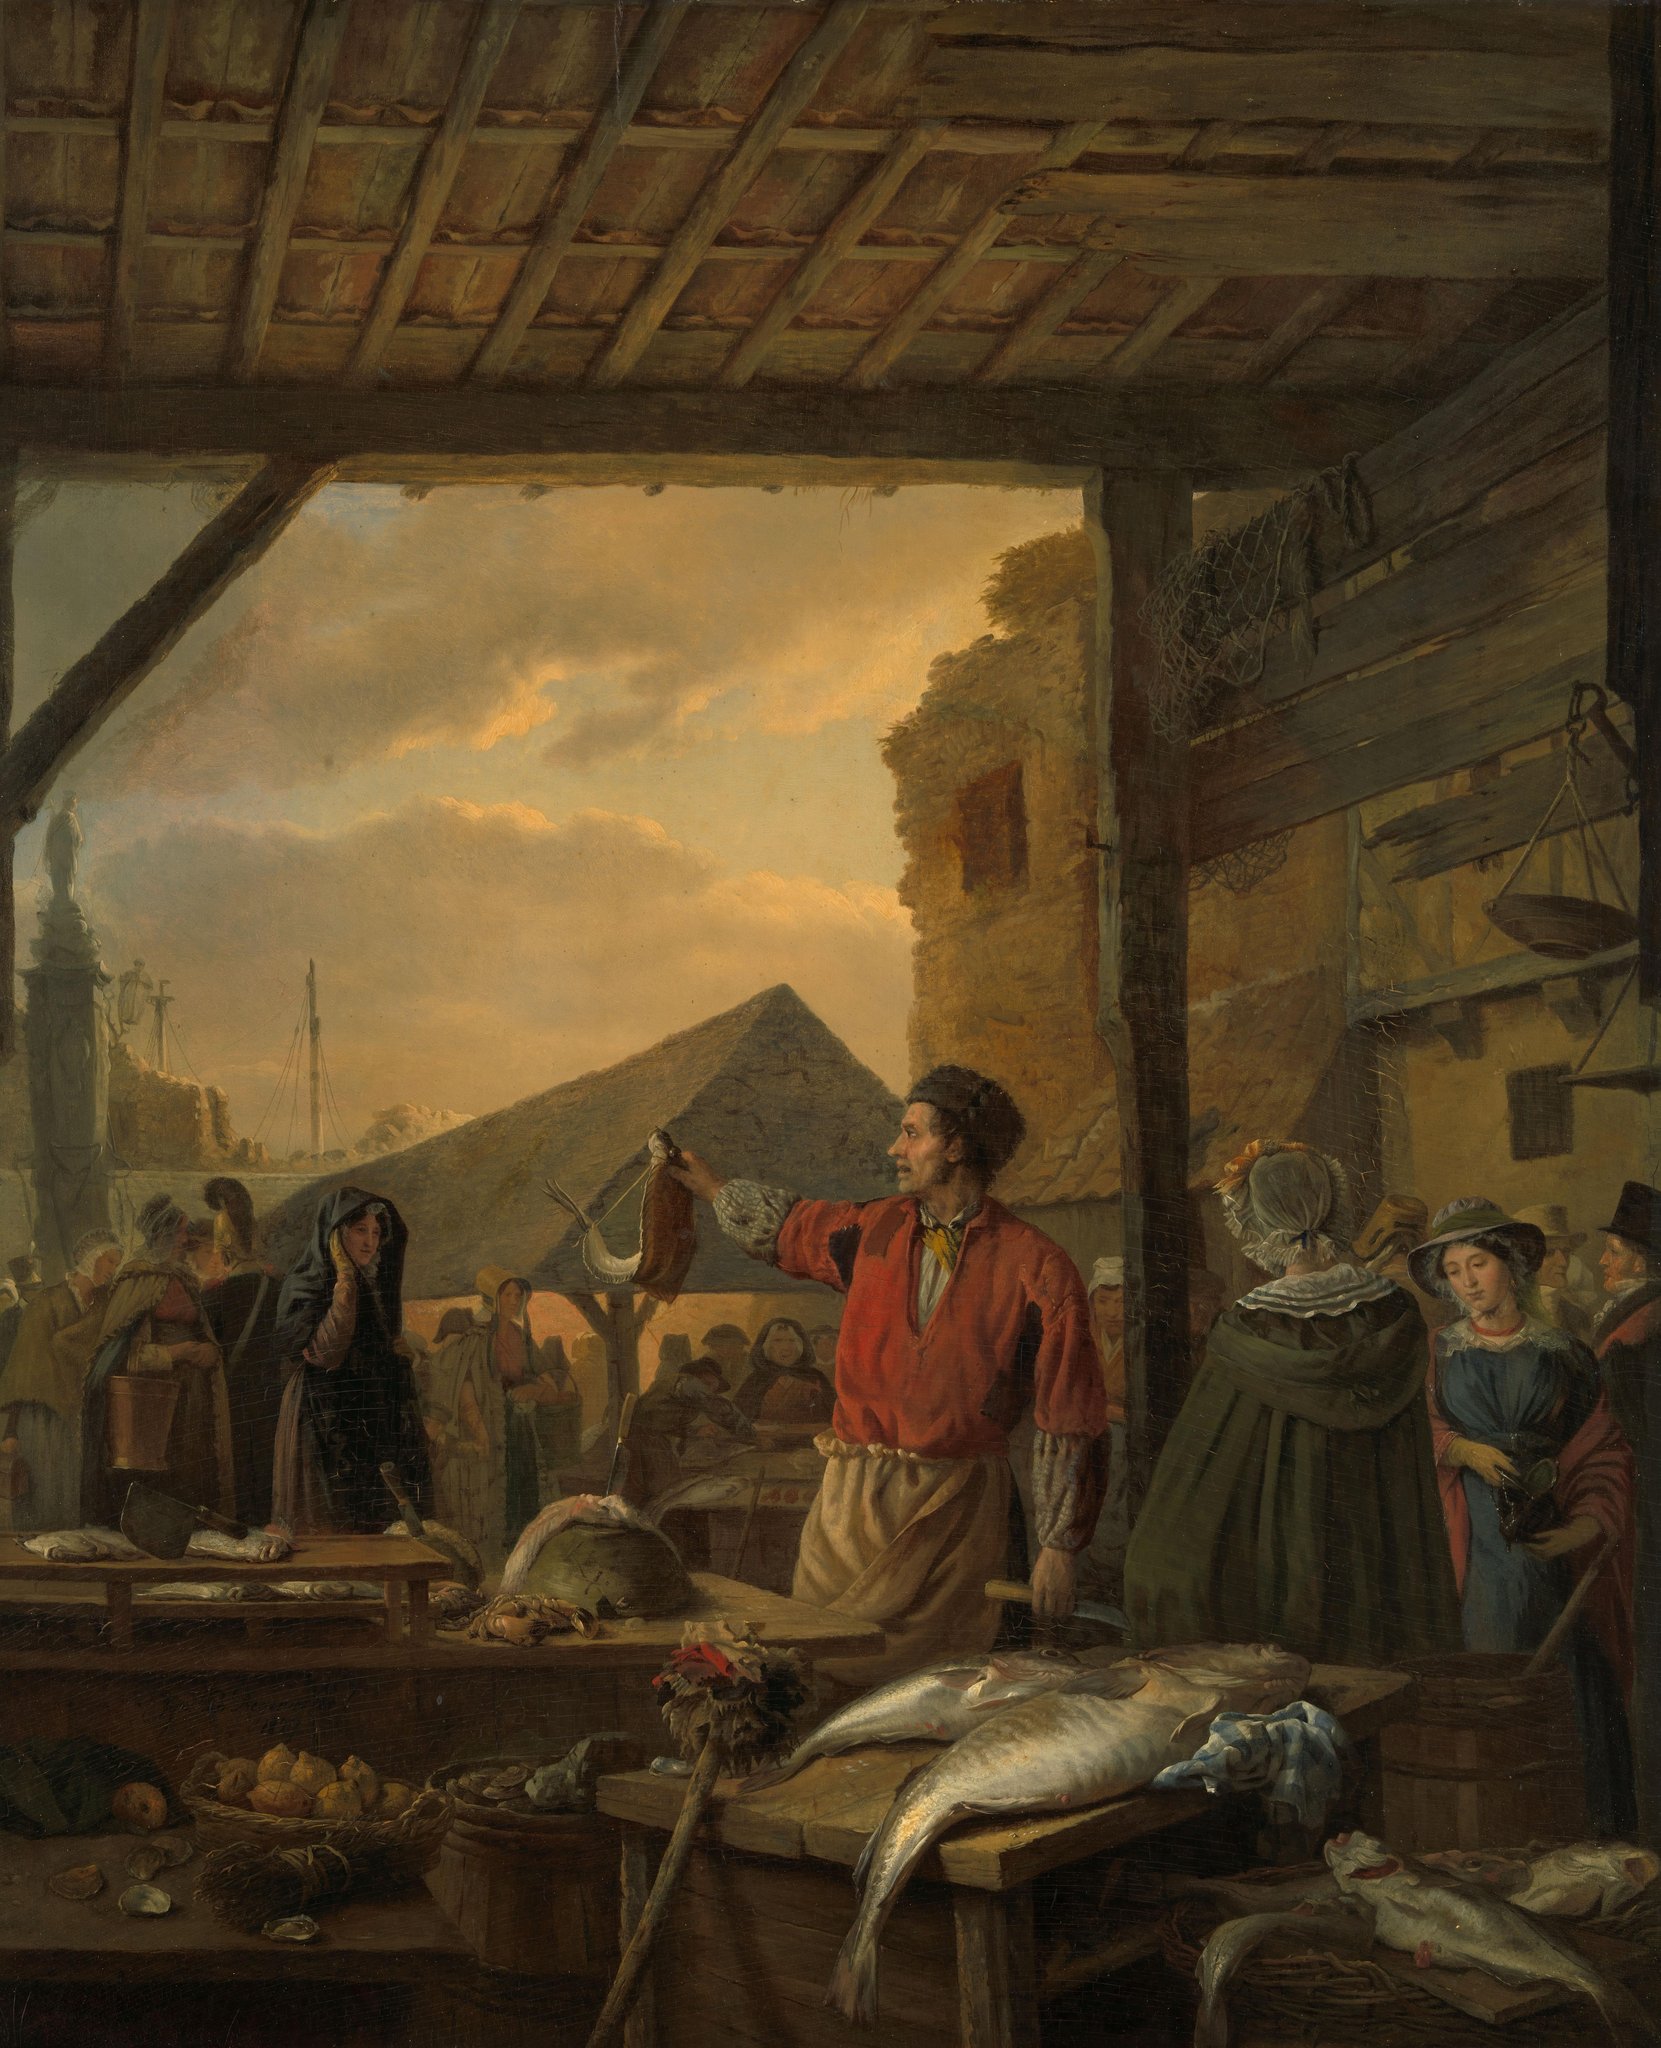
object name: painting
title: The Fish Market in Antwerp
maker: ignatius josephus van regemorter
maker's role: conservator, painter, print maker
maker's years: 1785-1873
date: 1827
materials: oil, panel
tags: commercial fishery, stall, booth (~ market), fish; still life of fishes, antwerp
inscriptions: signature and date: ‘Ign. van Regemorter f. 1827’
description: Gezicht op de vismarkt te Antwerpen. Bij een stal liggen verschillende soorten vis uitgestald, een visboer houdt een vis omhoog voor een vrouwelijke klant.